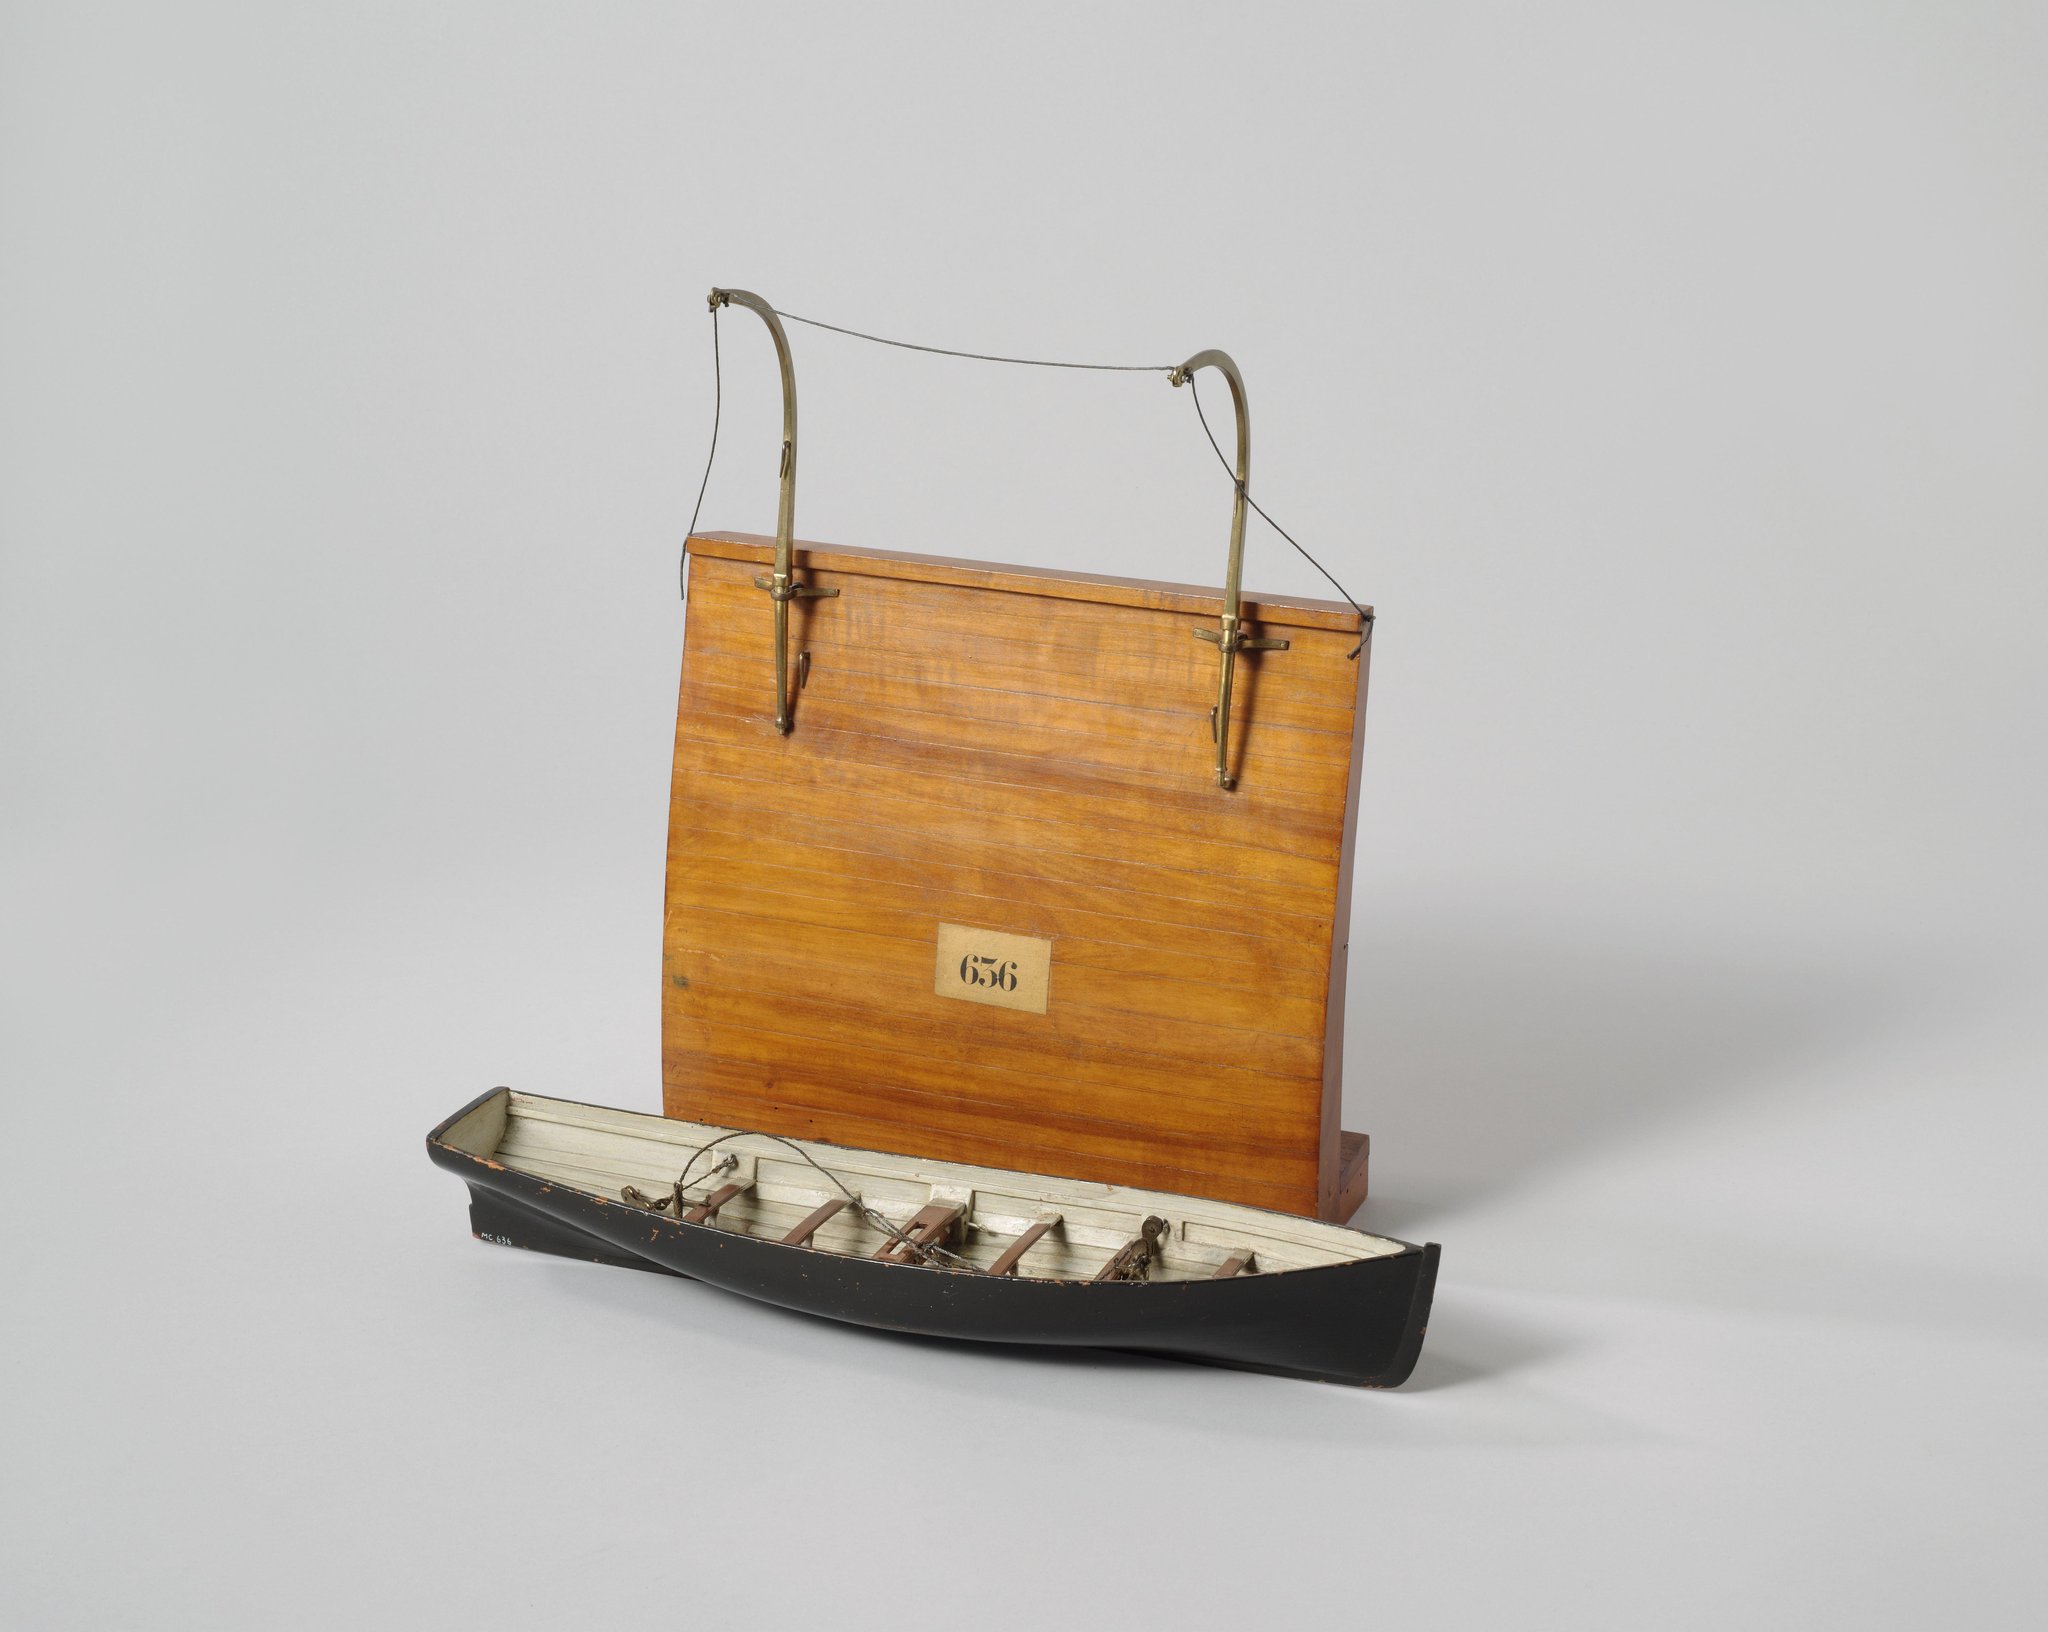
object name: demonstration model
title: Model of a Lifeboat Release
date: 1857-1858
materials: brass, fiber, wood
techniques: polychromy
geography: flushing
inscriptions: label: ‘636’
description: Model van een sloep. Het model demonstreert de sloepsval in de sloep. De sloep is een gladboordige dubbelriems sloep met platte spiegel, gepiekt rondspant en zeeg naar beide uiteinden oplopend; hij heeft zeven doften.